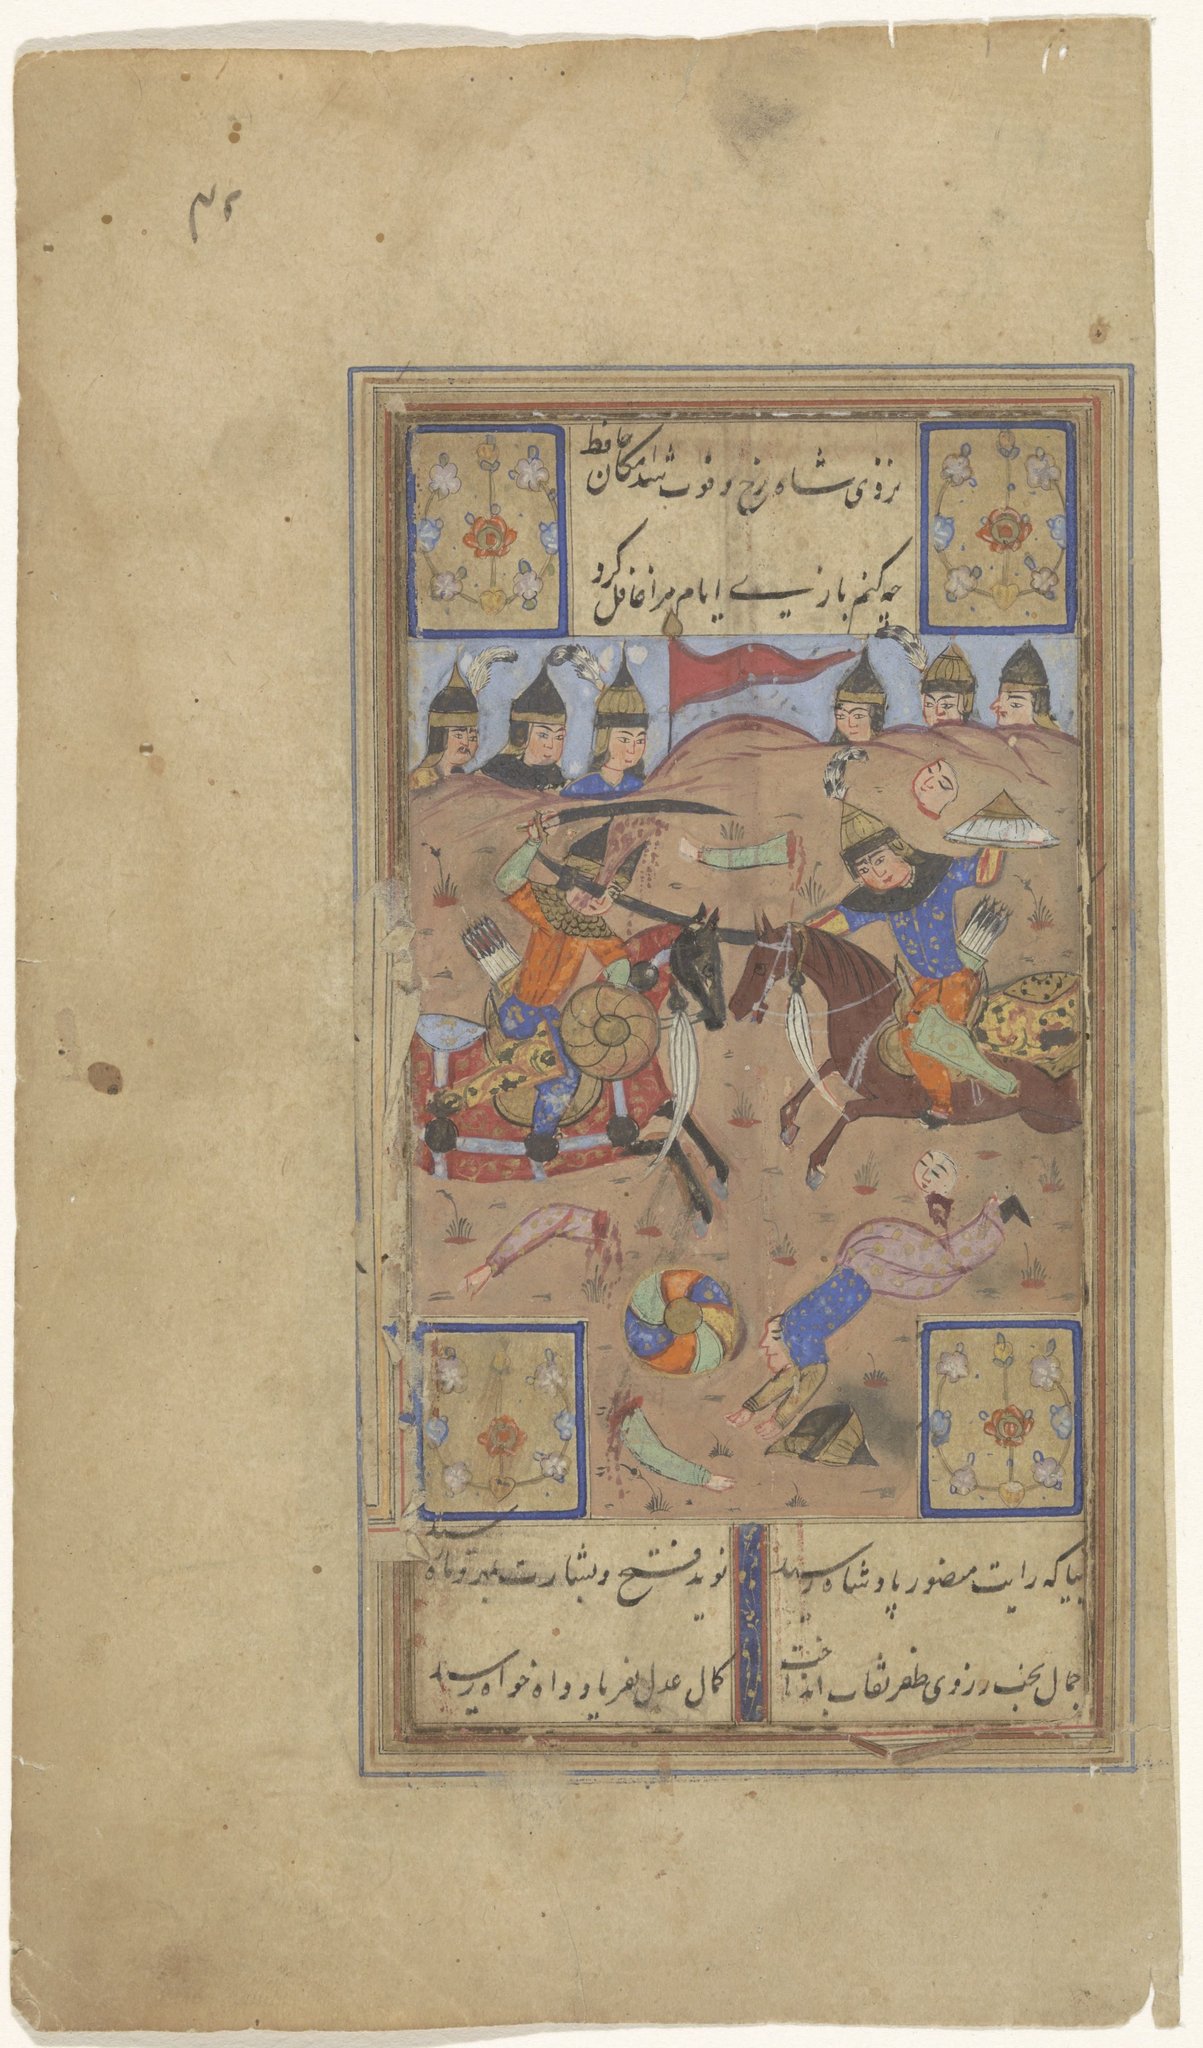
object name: persian miniature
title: Vechtscène tussen twee bereden krijger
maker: Anonymous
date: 1500-1800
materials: paper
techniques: brush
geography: iran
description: Een vechtscène tussen twee bereden krijgers; in de hoeken blokjes met een bloemenkrans en midden boven en onderaan blokjes tekst. Op verso twee verticale kolommen tekst, die halverwege door een horizontale band zijn doorkruist waarbinnen een blokje tekst en een blokje met bloemmotief aan weerskanten daarvan.